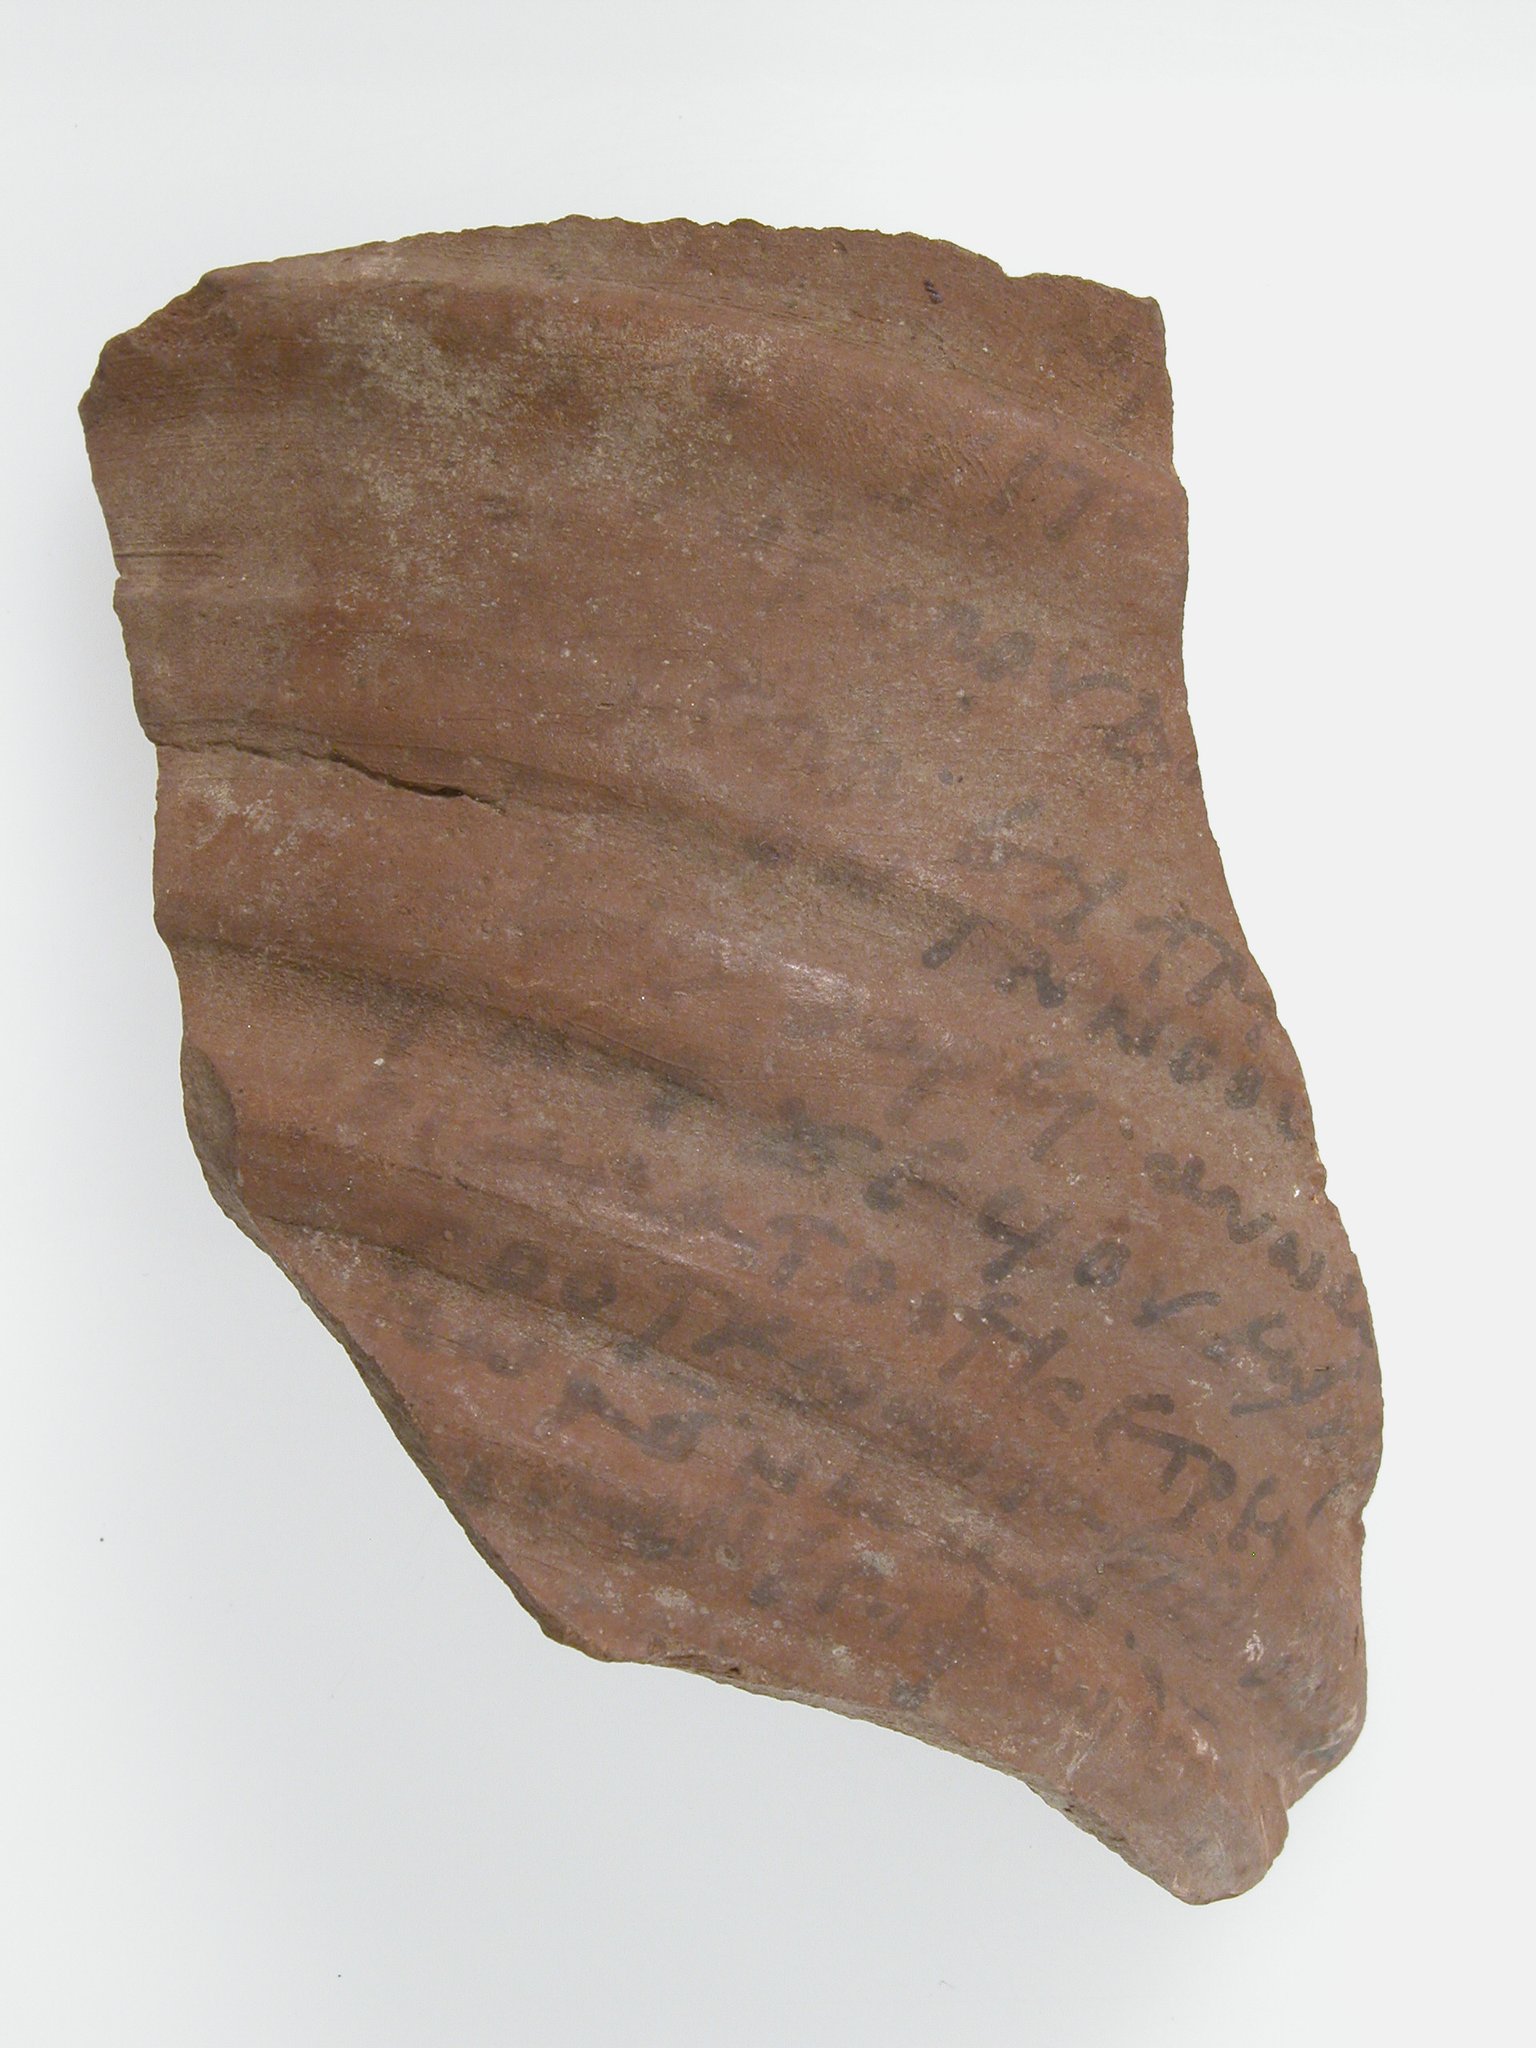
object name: ostrakon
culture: coptic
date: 601-700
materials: ink, pottery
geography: egypt